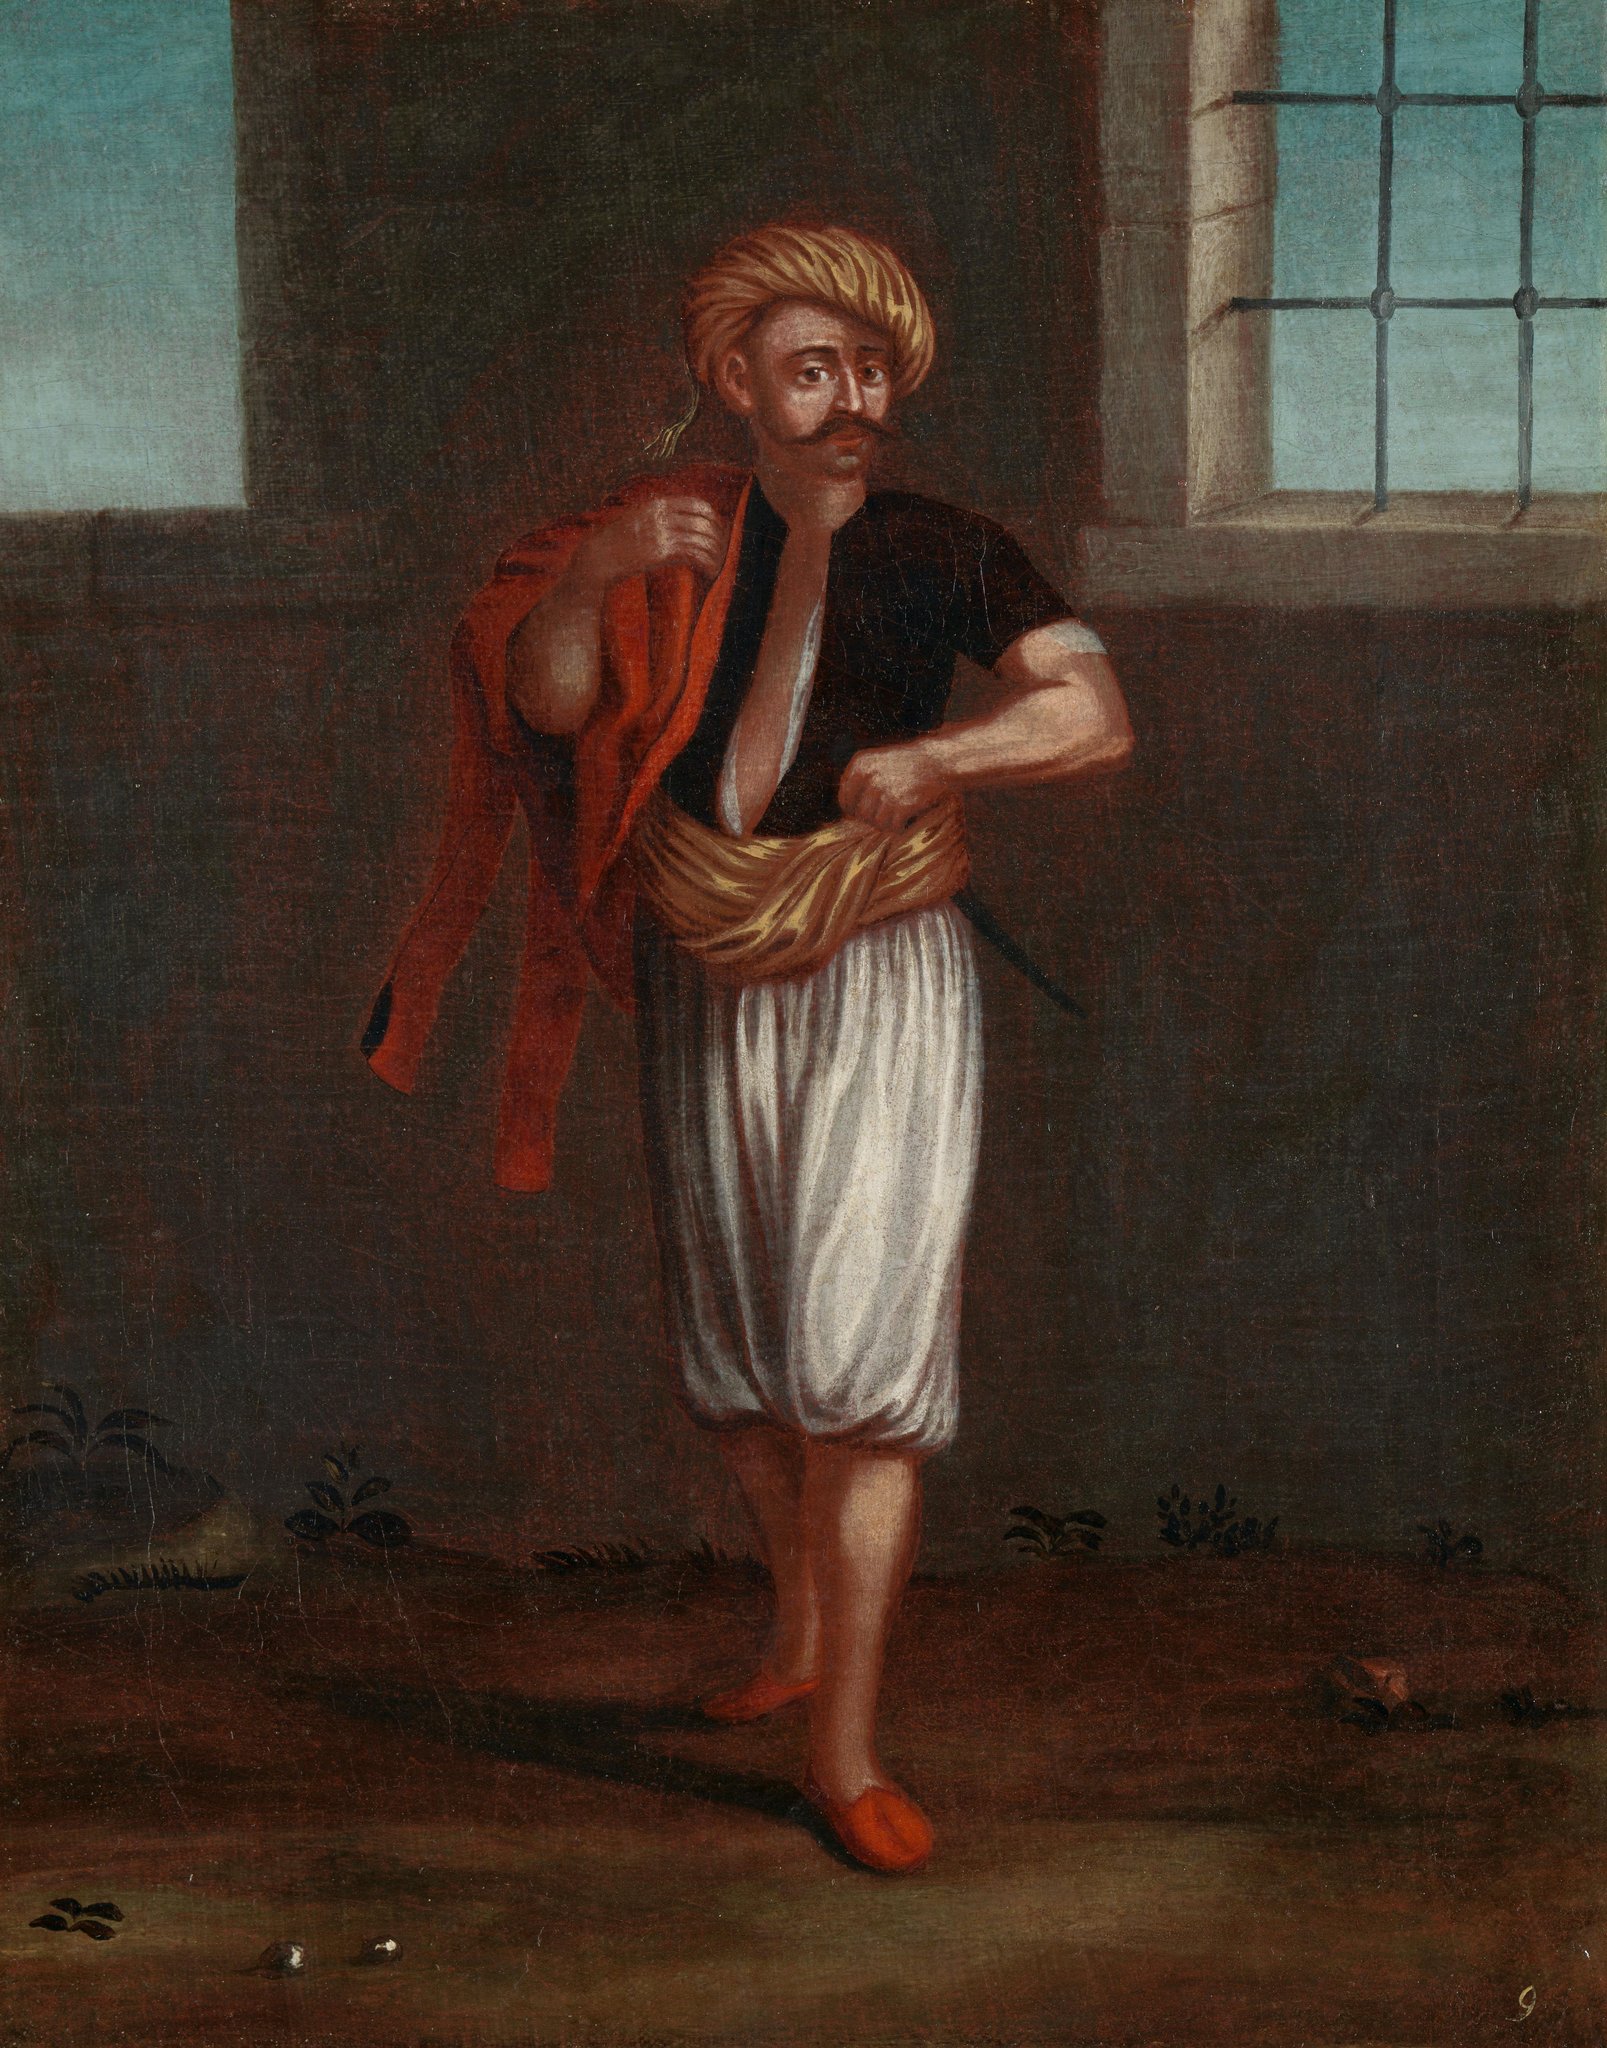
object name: painting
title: An Albanian Sailor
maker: jean baptiste vanmour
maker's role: painter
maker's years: 1671-1737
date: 1700-1737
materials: canvas, oil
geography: istanbul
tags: seaman, folk costume, regional costume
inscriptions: number: ‘9’, inscription: ‘Patrona off Rebell’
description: Een Albanese zeeman. Staande, ten voeten uit, voor een raam met tralies.